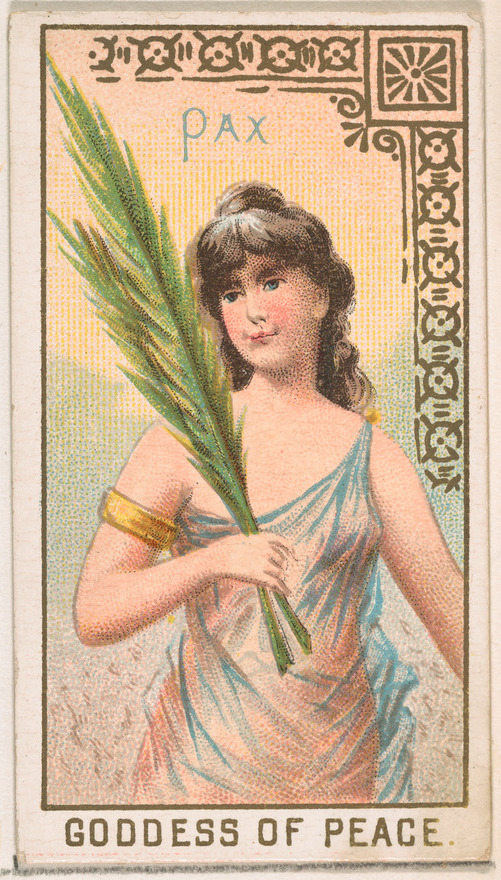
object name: print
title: Pax, Goddess of Peace, from the Goddesses of the Greeks and Romans series (N188) issued by Wm. S. Kimball & Co.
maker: william s. kimball & company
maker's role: publisher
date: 1889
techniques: color lithograph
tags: goddess